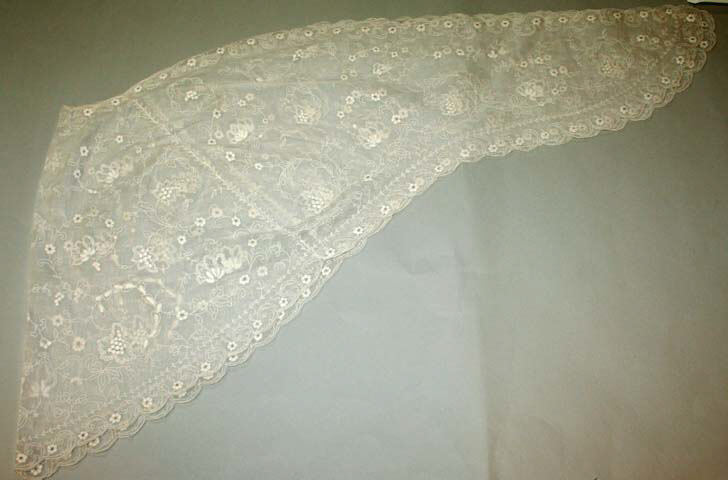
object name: fichu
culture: american or european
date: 1801-1833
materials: cotton